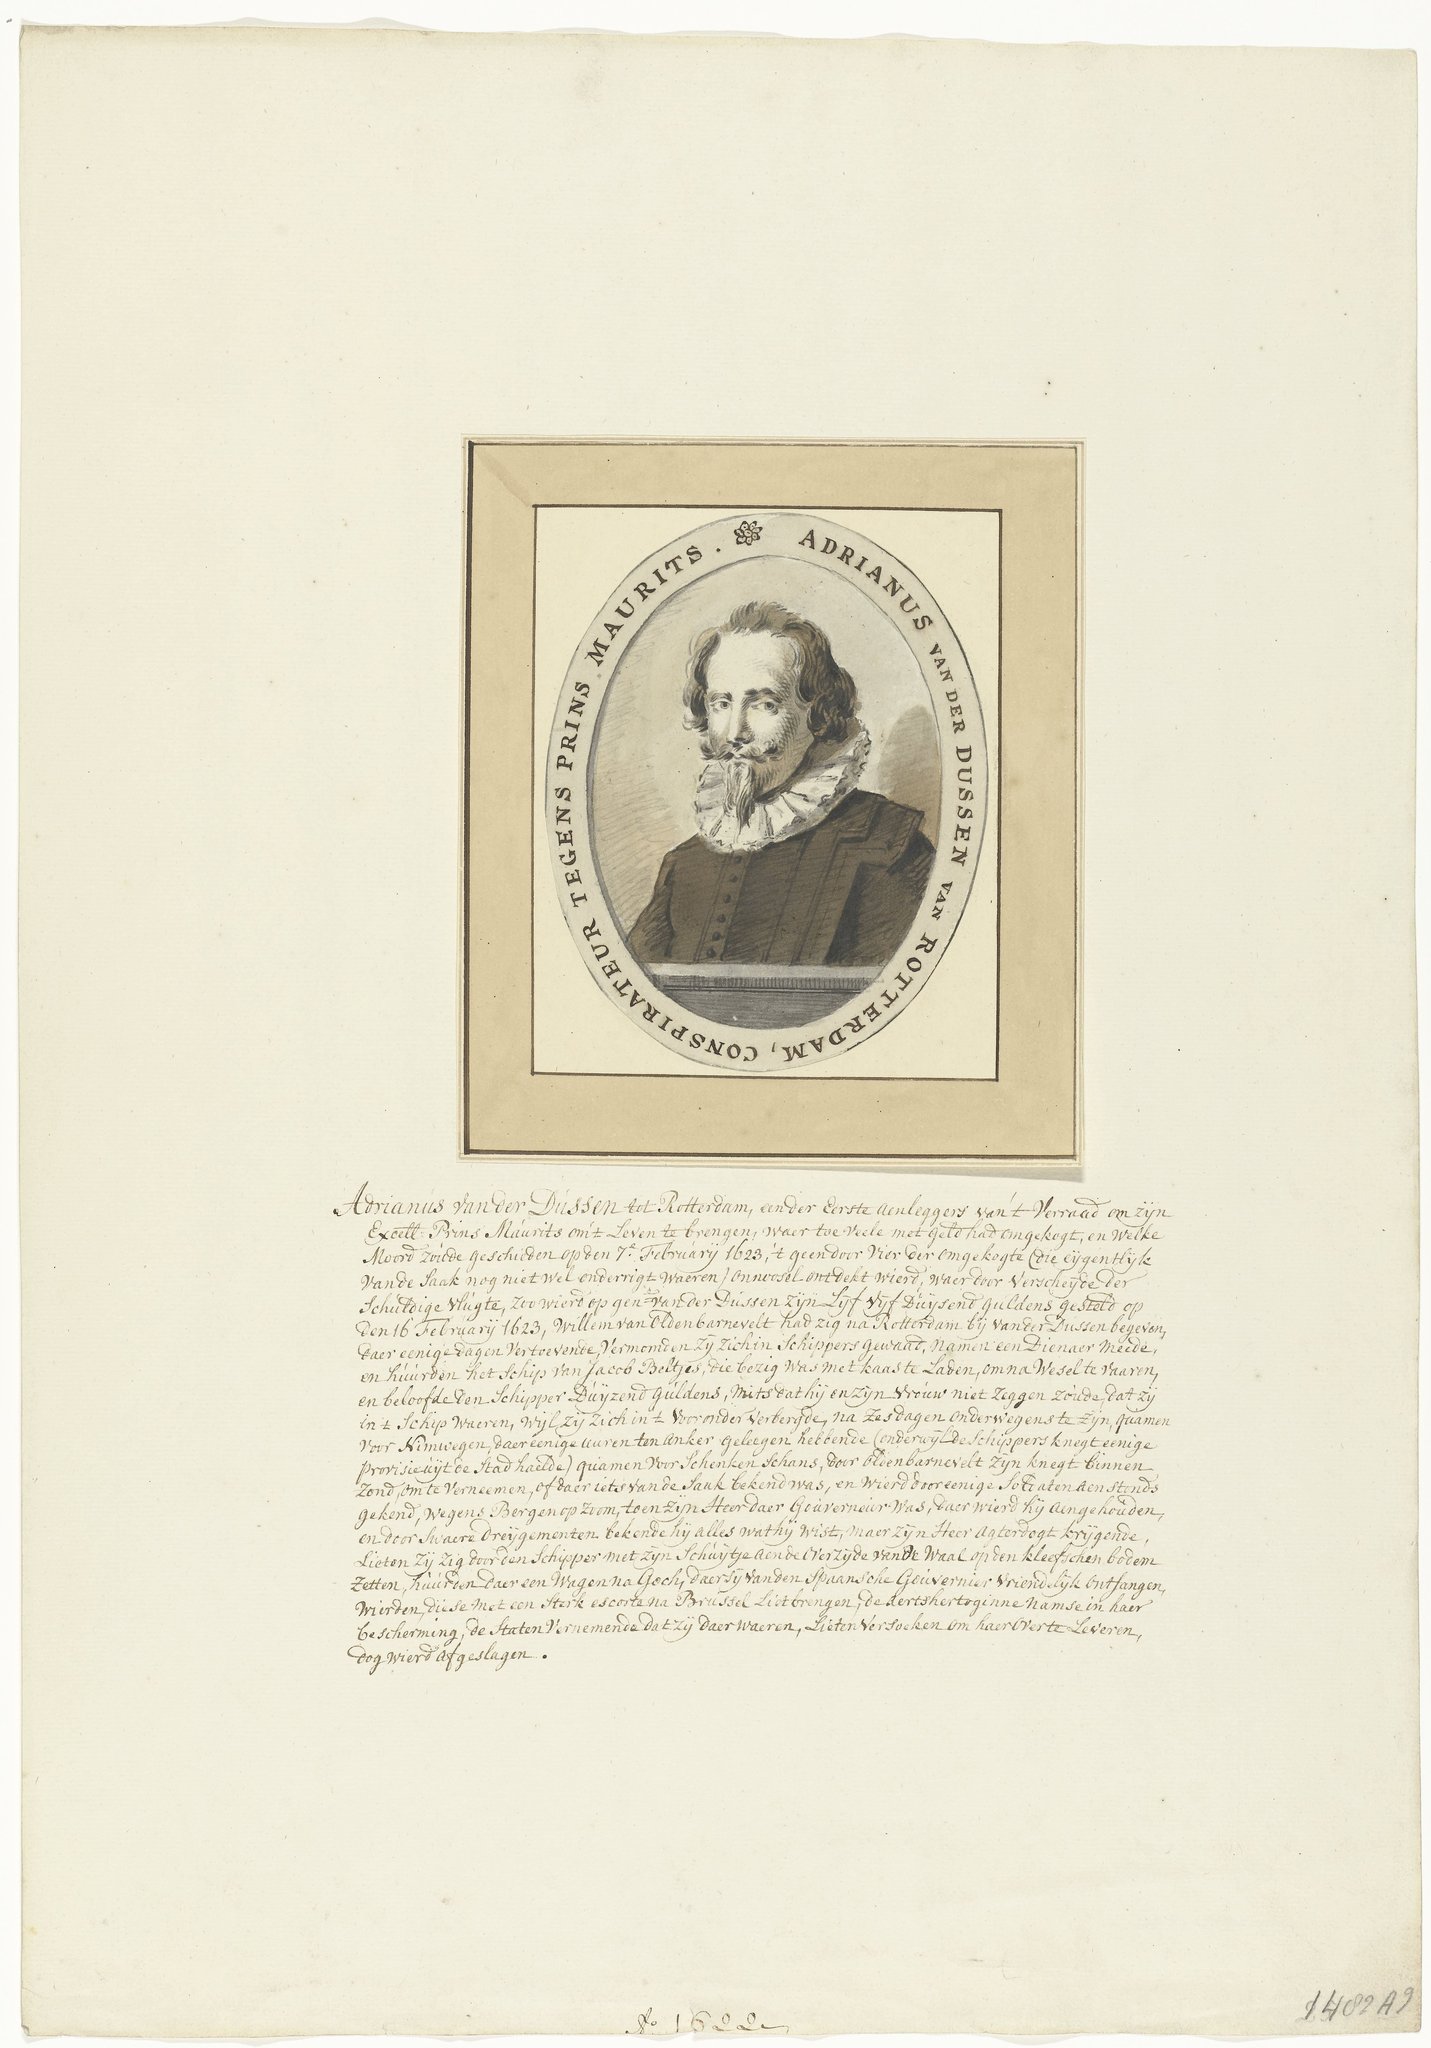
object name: historieplaat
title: Portret van Adriaan van der Dussen, 1623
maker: tako hajo jelgersma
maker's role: draughtsman, painter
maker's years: 1702-1795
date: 1715-1795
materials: paper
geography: netherlands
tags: bruges, (revolutionary) plot, conspiracy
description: Portret van Adriaan van der Dussen, één van de samenzweerders tegen Maurits in 1623. Borstbeeld in ovaal, naar links. Met randschrift in het Nederlands. Op het blad onder het opgeplakte portret een handgeschreven levensbeschrijving van de afgebeelde persoon.